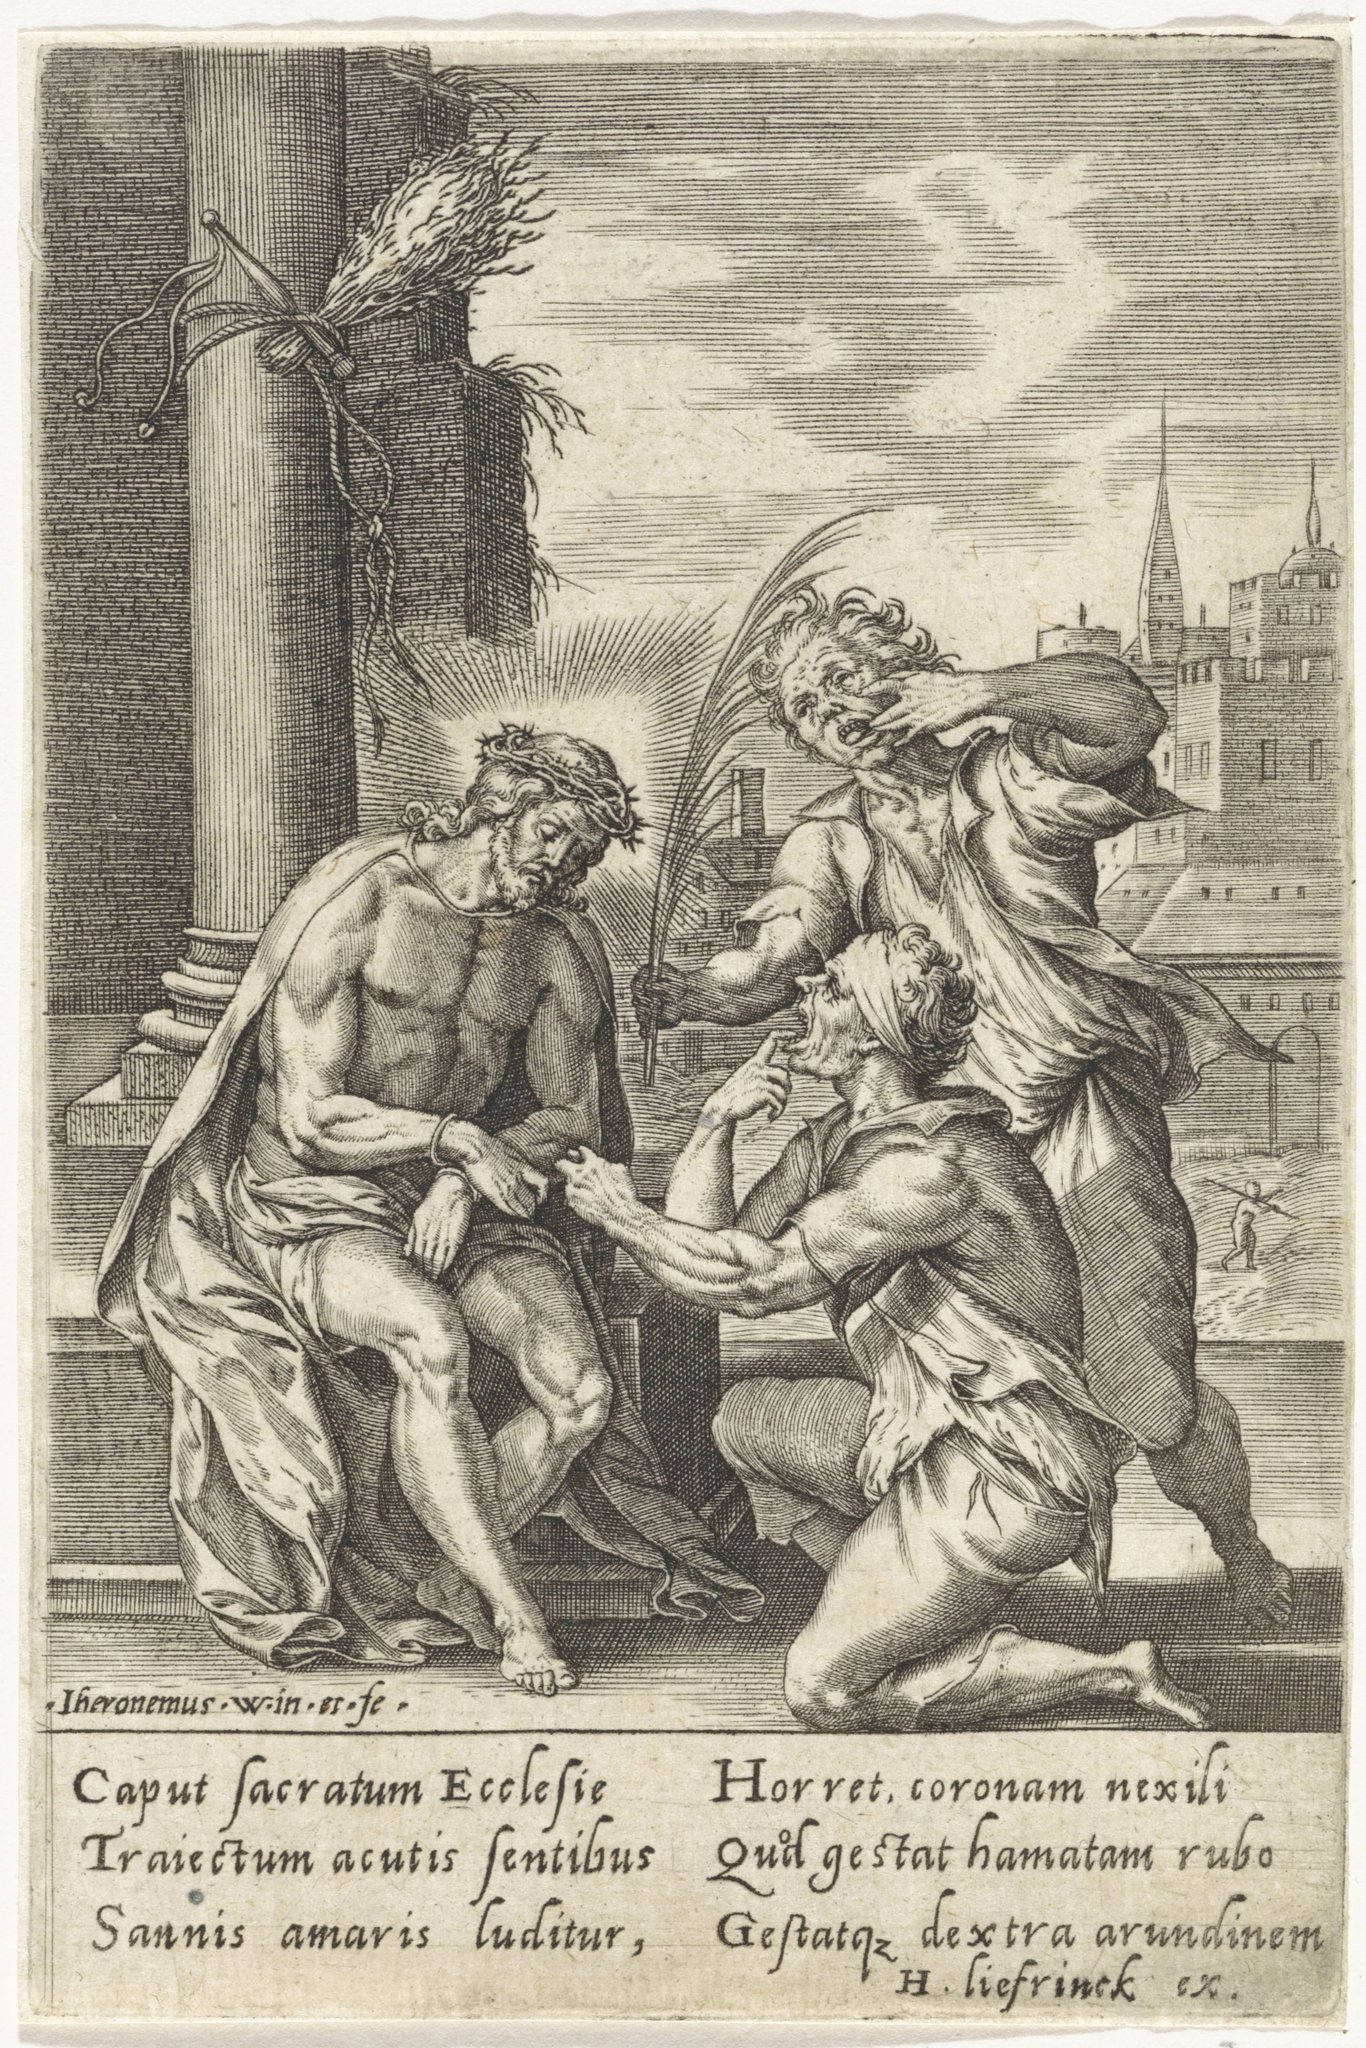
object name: print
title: Bespotting van Christus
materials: paper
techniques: engraving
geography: antwerp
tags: in caiaphas' palace christ is mocked by jews (matthew 26:67-68; mark 14:65)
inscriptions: collector's mark: Lugt 2228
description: De met touwen geboeide Christus wordt na zijn doornenkroning bespot door twee joden. Aan de zuil achter hem zijn de gesels gebonden. In de marge een zesregelig onderschrift, in twee kolommen, in het Latijn.